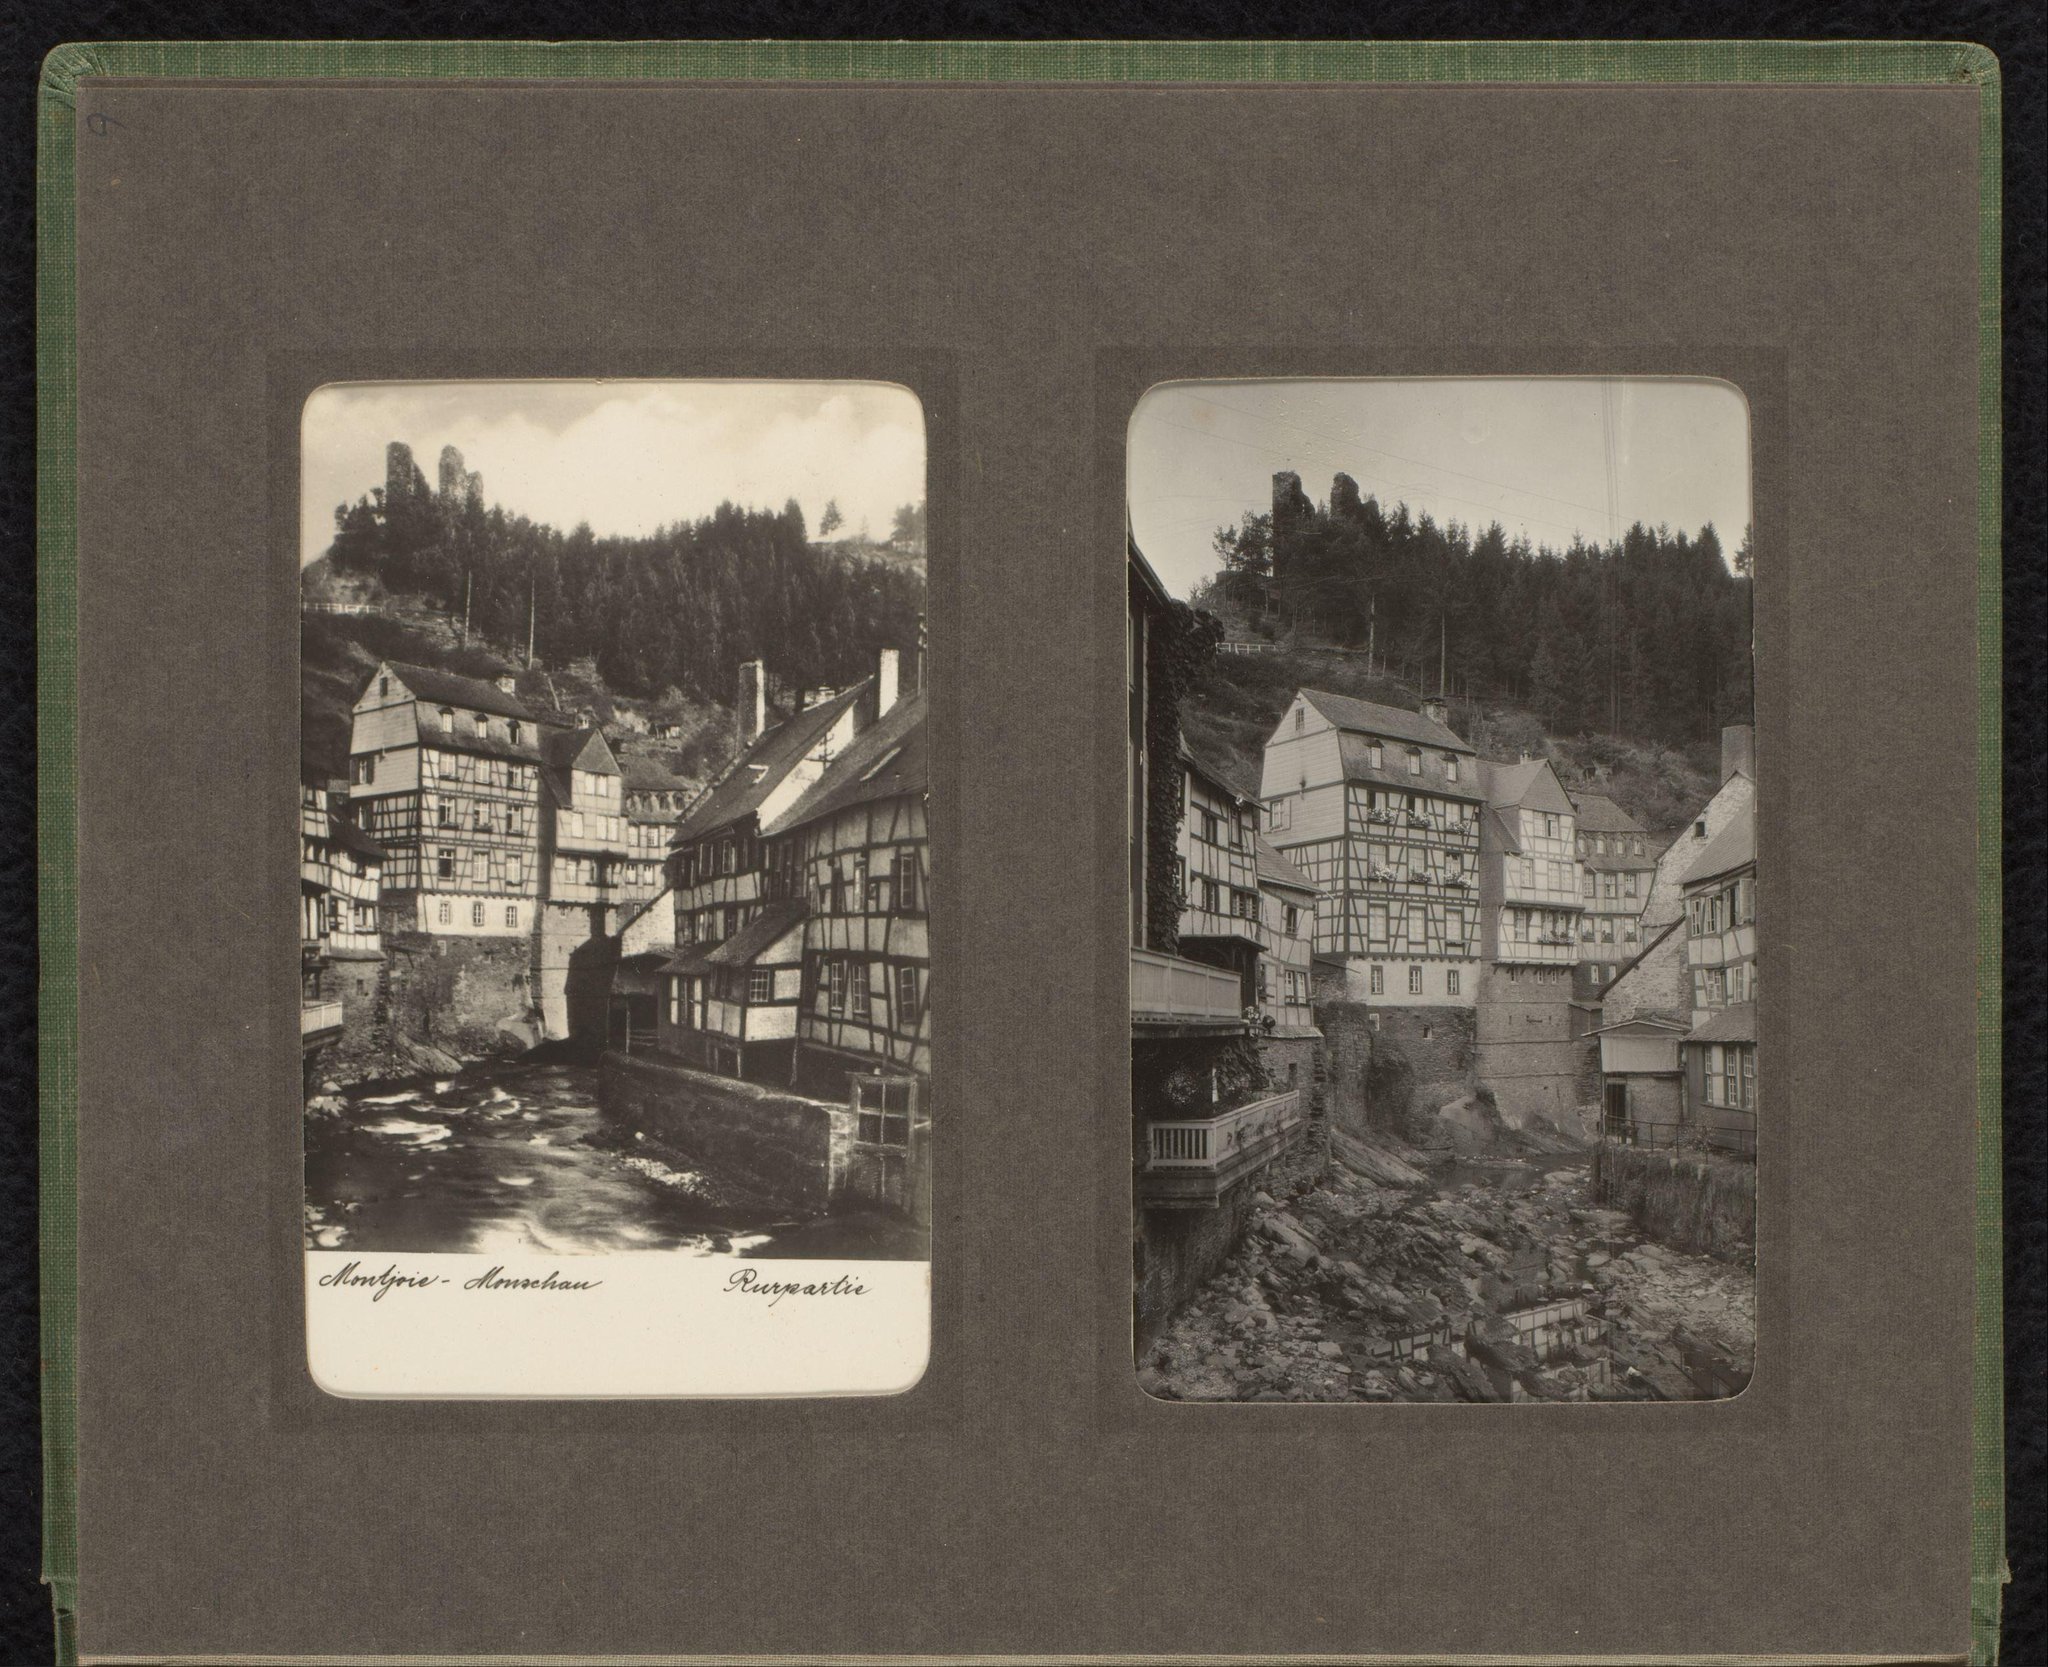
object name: ansichtkaart, prentbriefkaart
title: Twee foto's, waarvan één prentbriefkaart, met gezichten op Monschau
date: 1909-1932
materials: paper, cardboard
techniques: gelatin silver print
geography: monschau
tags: urban housing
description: Deze foto's maken deel uit van een album.